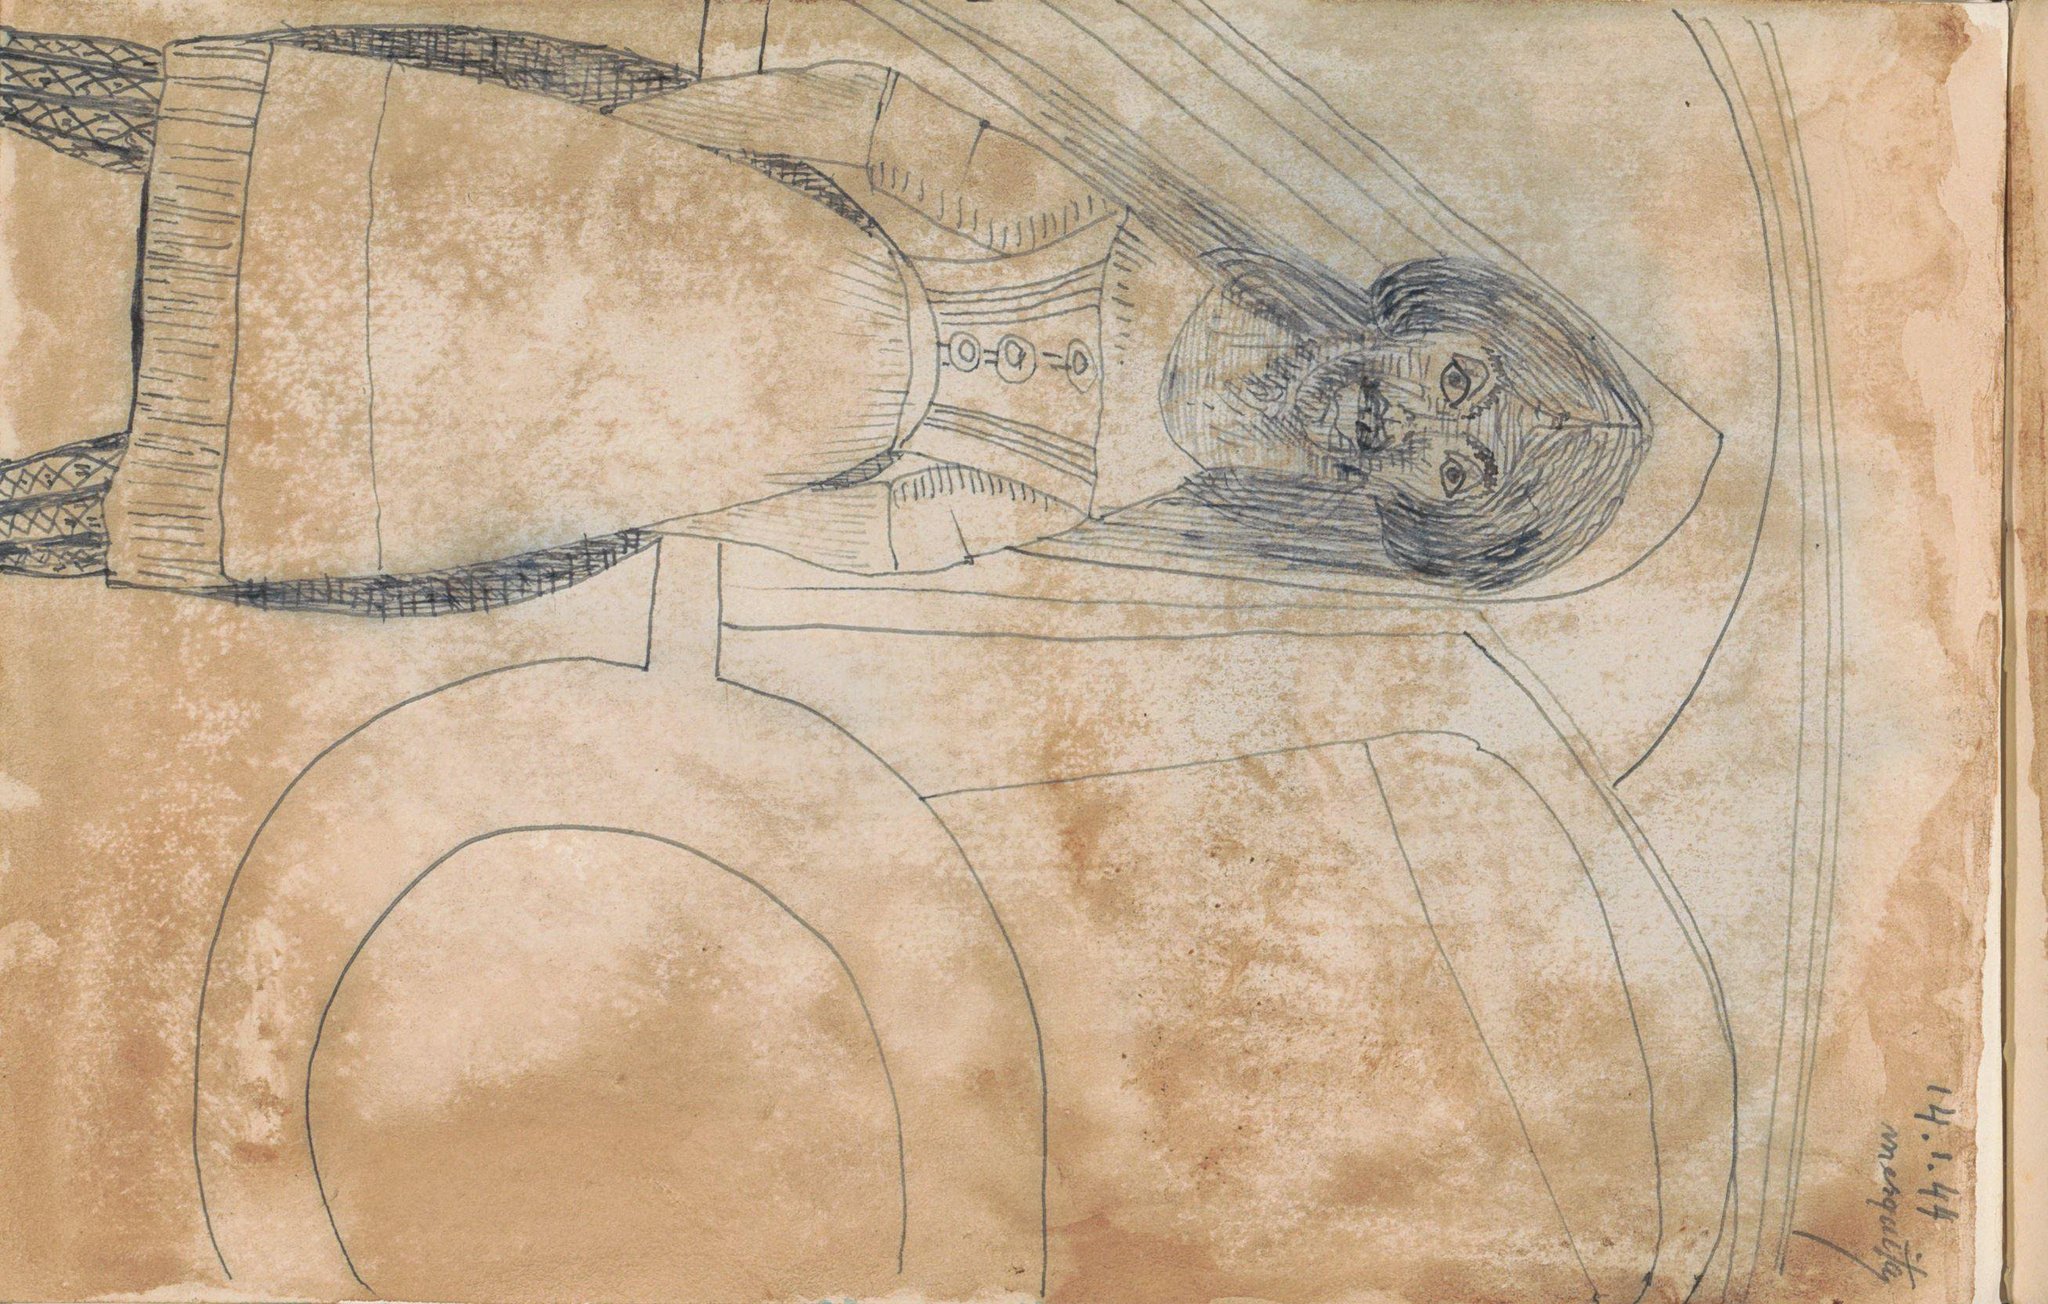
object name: sketchbook leaf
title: Figuur met lang haar en een baard, gekleed in een jurk met knopen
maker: samuel jessurun de mesquita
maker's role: draughtsman, print maker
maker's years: 1868-1944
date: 1944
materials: ink, paper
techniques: brush, pen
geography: amsterdam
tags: man dressed as woman, travesty, anatomy (non-medical), beard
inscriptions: signature and date: ‘14.1.44/ mesquita’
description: Achter de figuur een cirkel verbonden met een rechthoek en andere vormen. Blad 14 verso uit een schetsboek met 18 bladen.